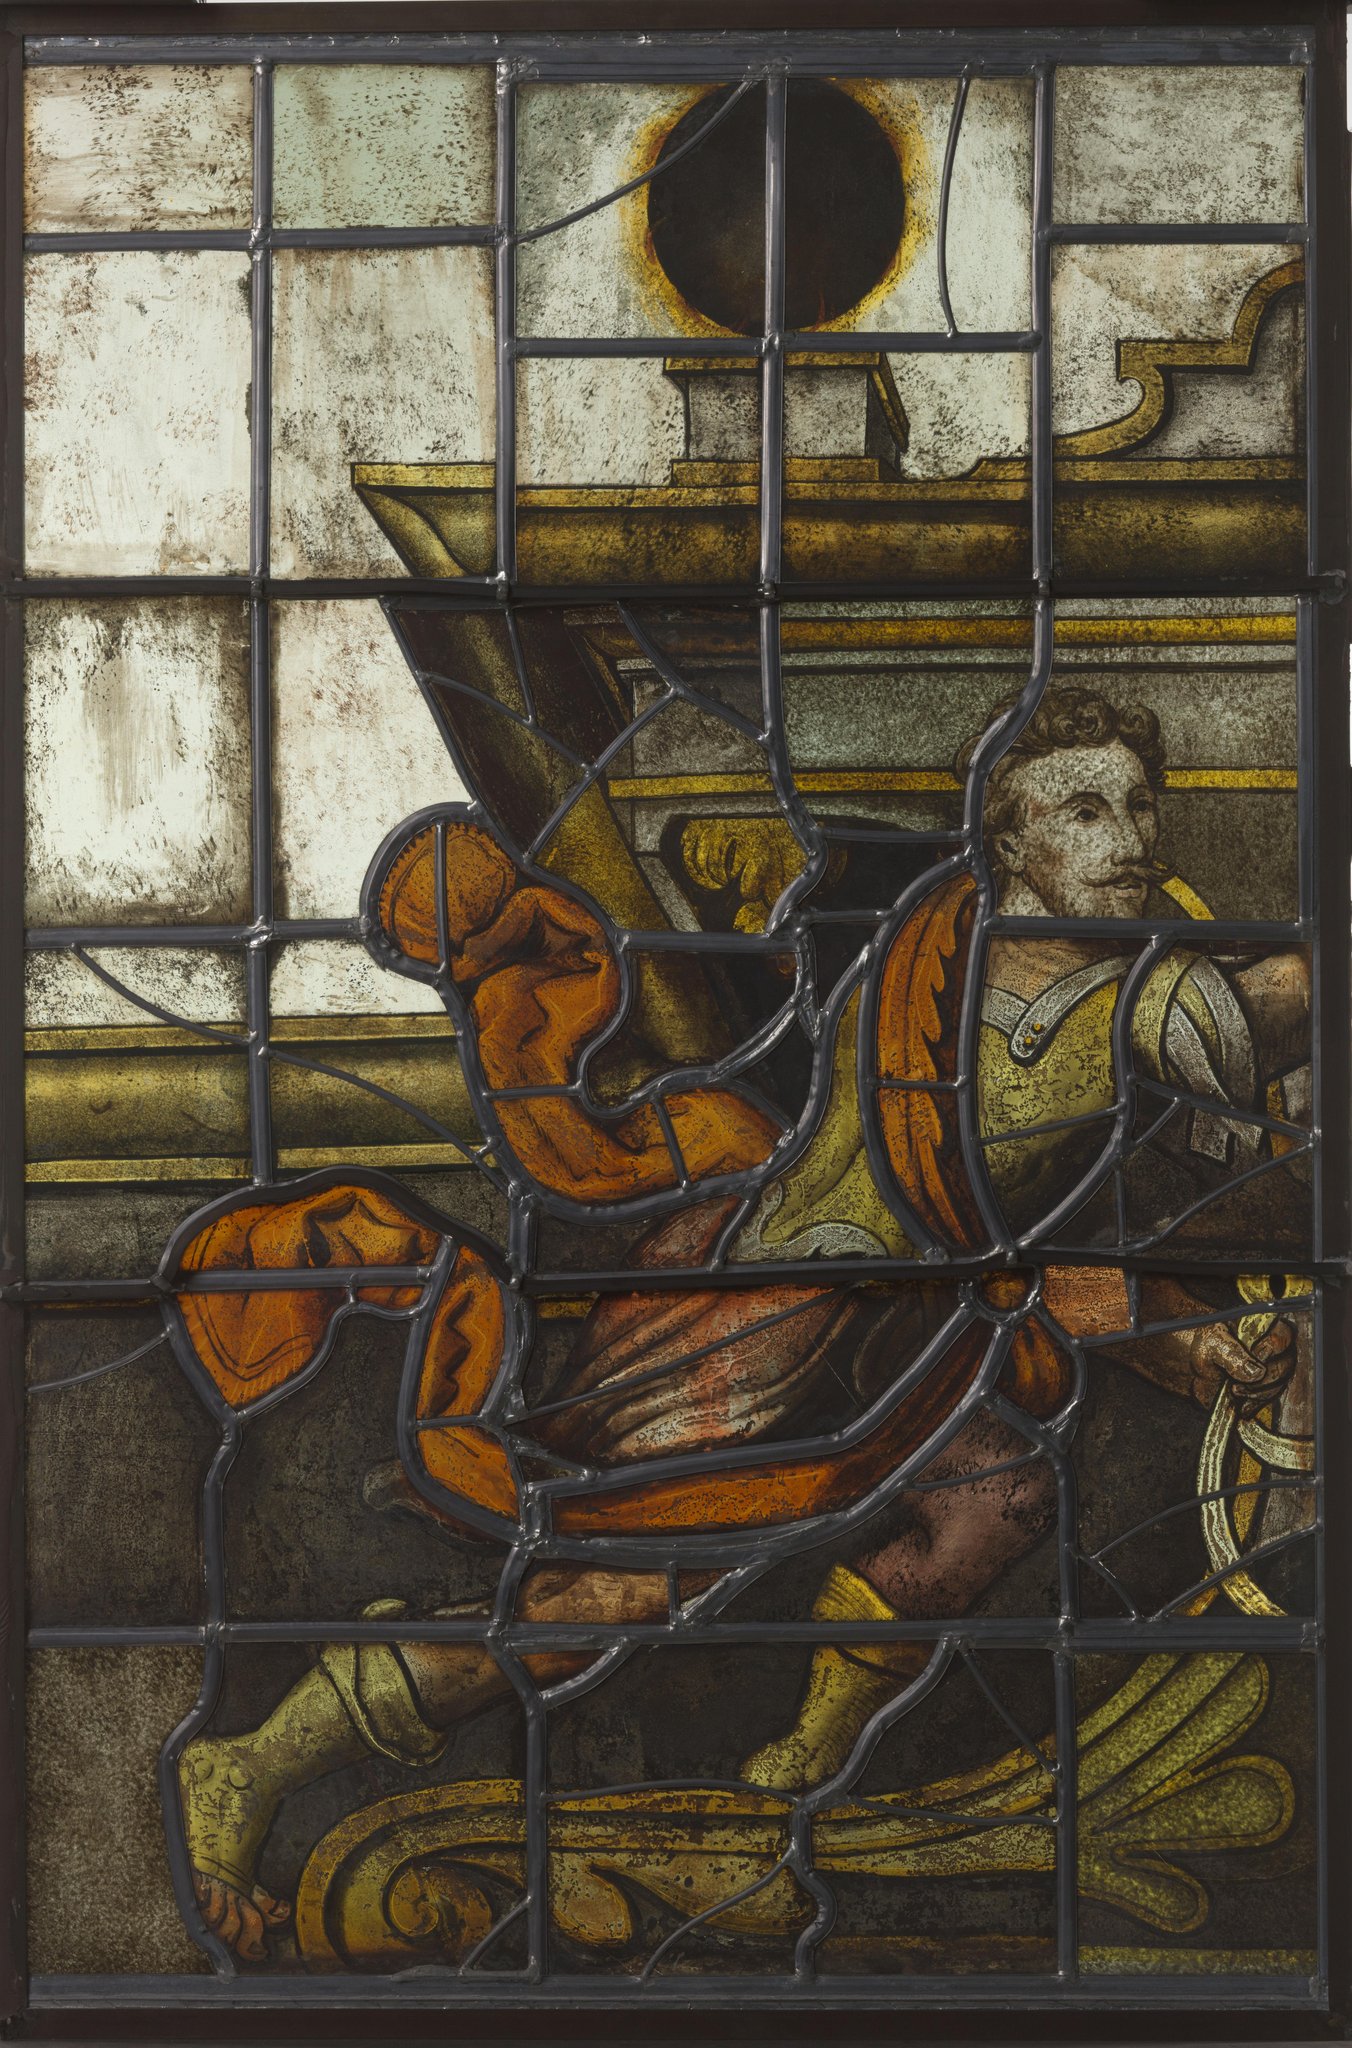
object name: light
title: Dertiende paneel van ruit met Prins Maurits in biddende houding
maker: Anonymous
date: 1618-1620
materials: glass, lead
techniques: leading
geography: netherlands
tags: the hague, maurice (prince of orange)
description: Groot raam afkomstig uit het klooster van St Agatha bij Cuyk. Prins Maurits in verguld harnas, met hermelijnen mantel en geplooide kraag, blootshoofds, in biddende houding, geknield op een bidstoel voor een lessenaar waarop een boek. De lessenaar staat op een tafel met een donkerblauw kleed met gouden franje gedekt. Helm en handschoenen liggen op de grond voor de tafel. De prins bevindt zich in een koepel door vier vrijstaande Korintische zuilen gedragen; boven zijn hoofd een baldakijn waaruit een lauwerkrans afhangt. De koepel wordt bekroond door het wapen van Maurits en het devies van de Orde van de Kousenband: 'Honi soit qui mal y pense' (Schande over hem die er kwaad van denkt). Wapen door twee lopende jongelingen gesteund. Het wapen leunt tegen het bovenstuk van de koepel. Onder dit tafereel bevinden zich brokstukken architectuur die onoordeelkundig zijn aangebracht. Rechts ligt een jonge vrouw geknield met opgeheven handen. Zij draagt een geel zijden mantel met hermelijn omzoomd. Het gezicht is in olieverf bijgemaakt in 1891.